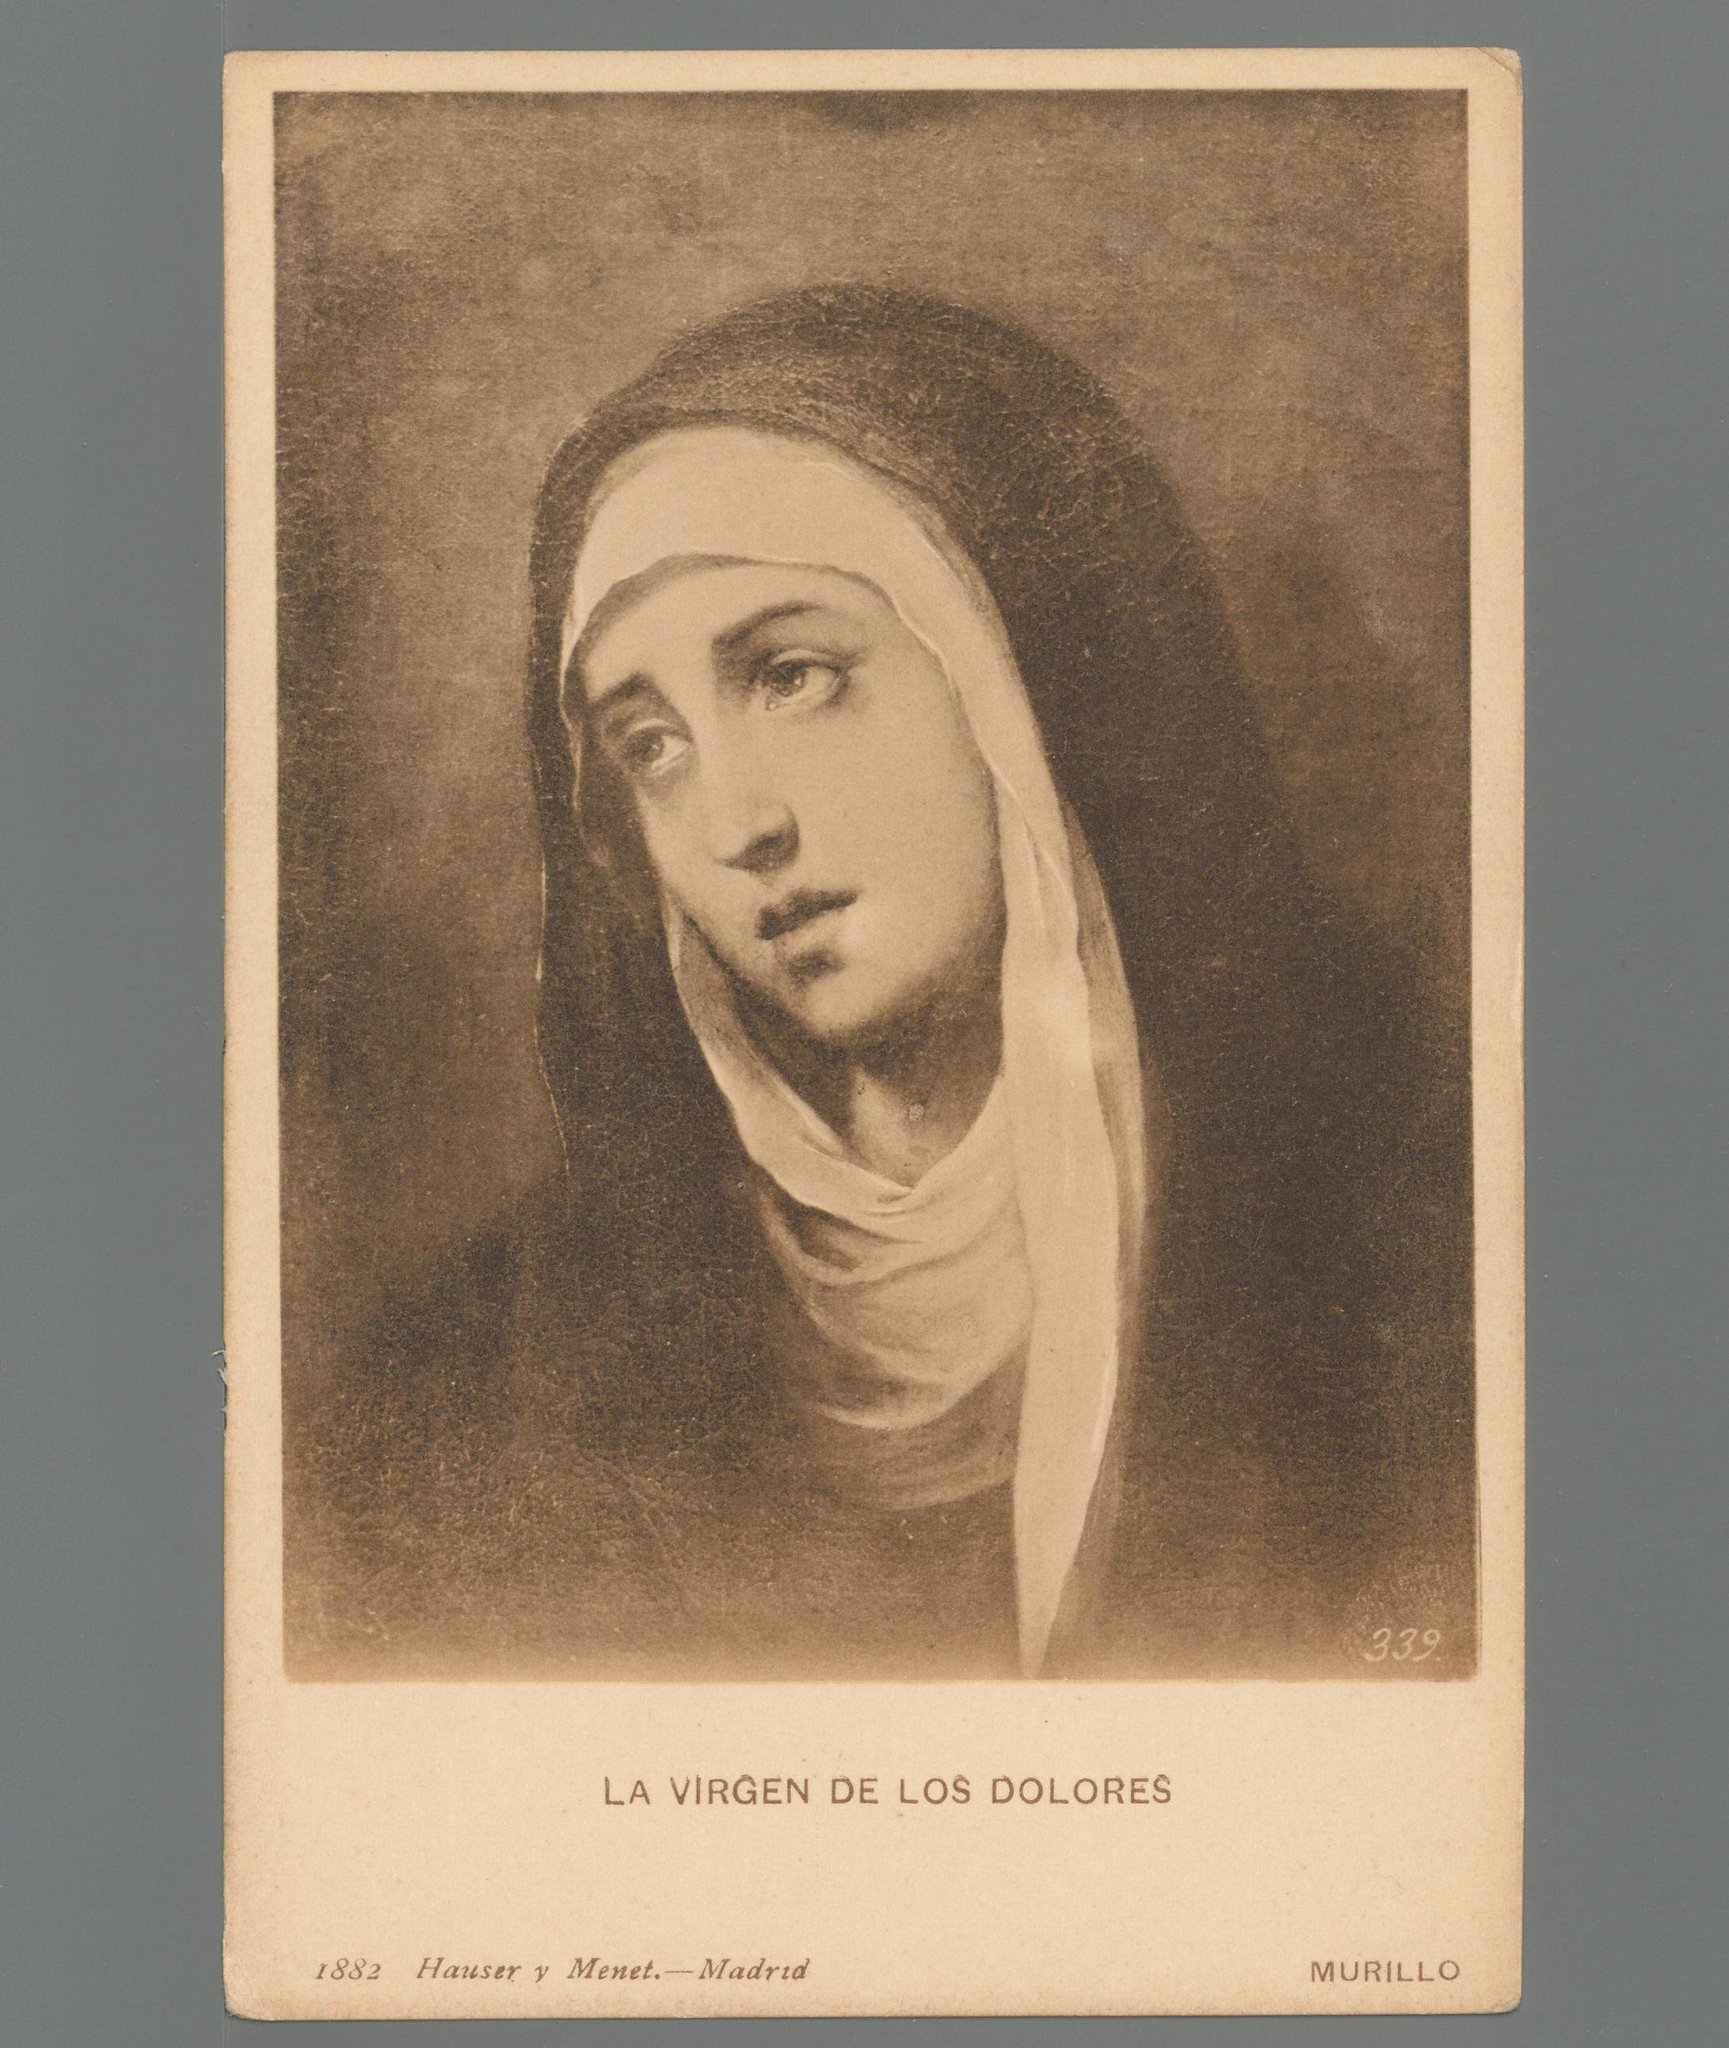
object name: reproduction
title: La Virgen de los Dolores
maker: bartolomé esteban murillo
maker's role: draughtsman, painter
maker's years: 1617-1682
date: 1890-1905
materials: cardboard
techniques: photograph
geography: madrid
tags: 'mater dolorosa'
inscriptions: collector's mark: ‘AFE v S’